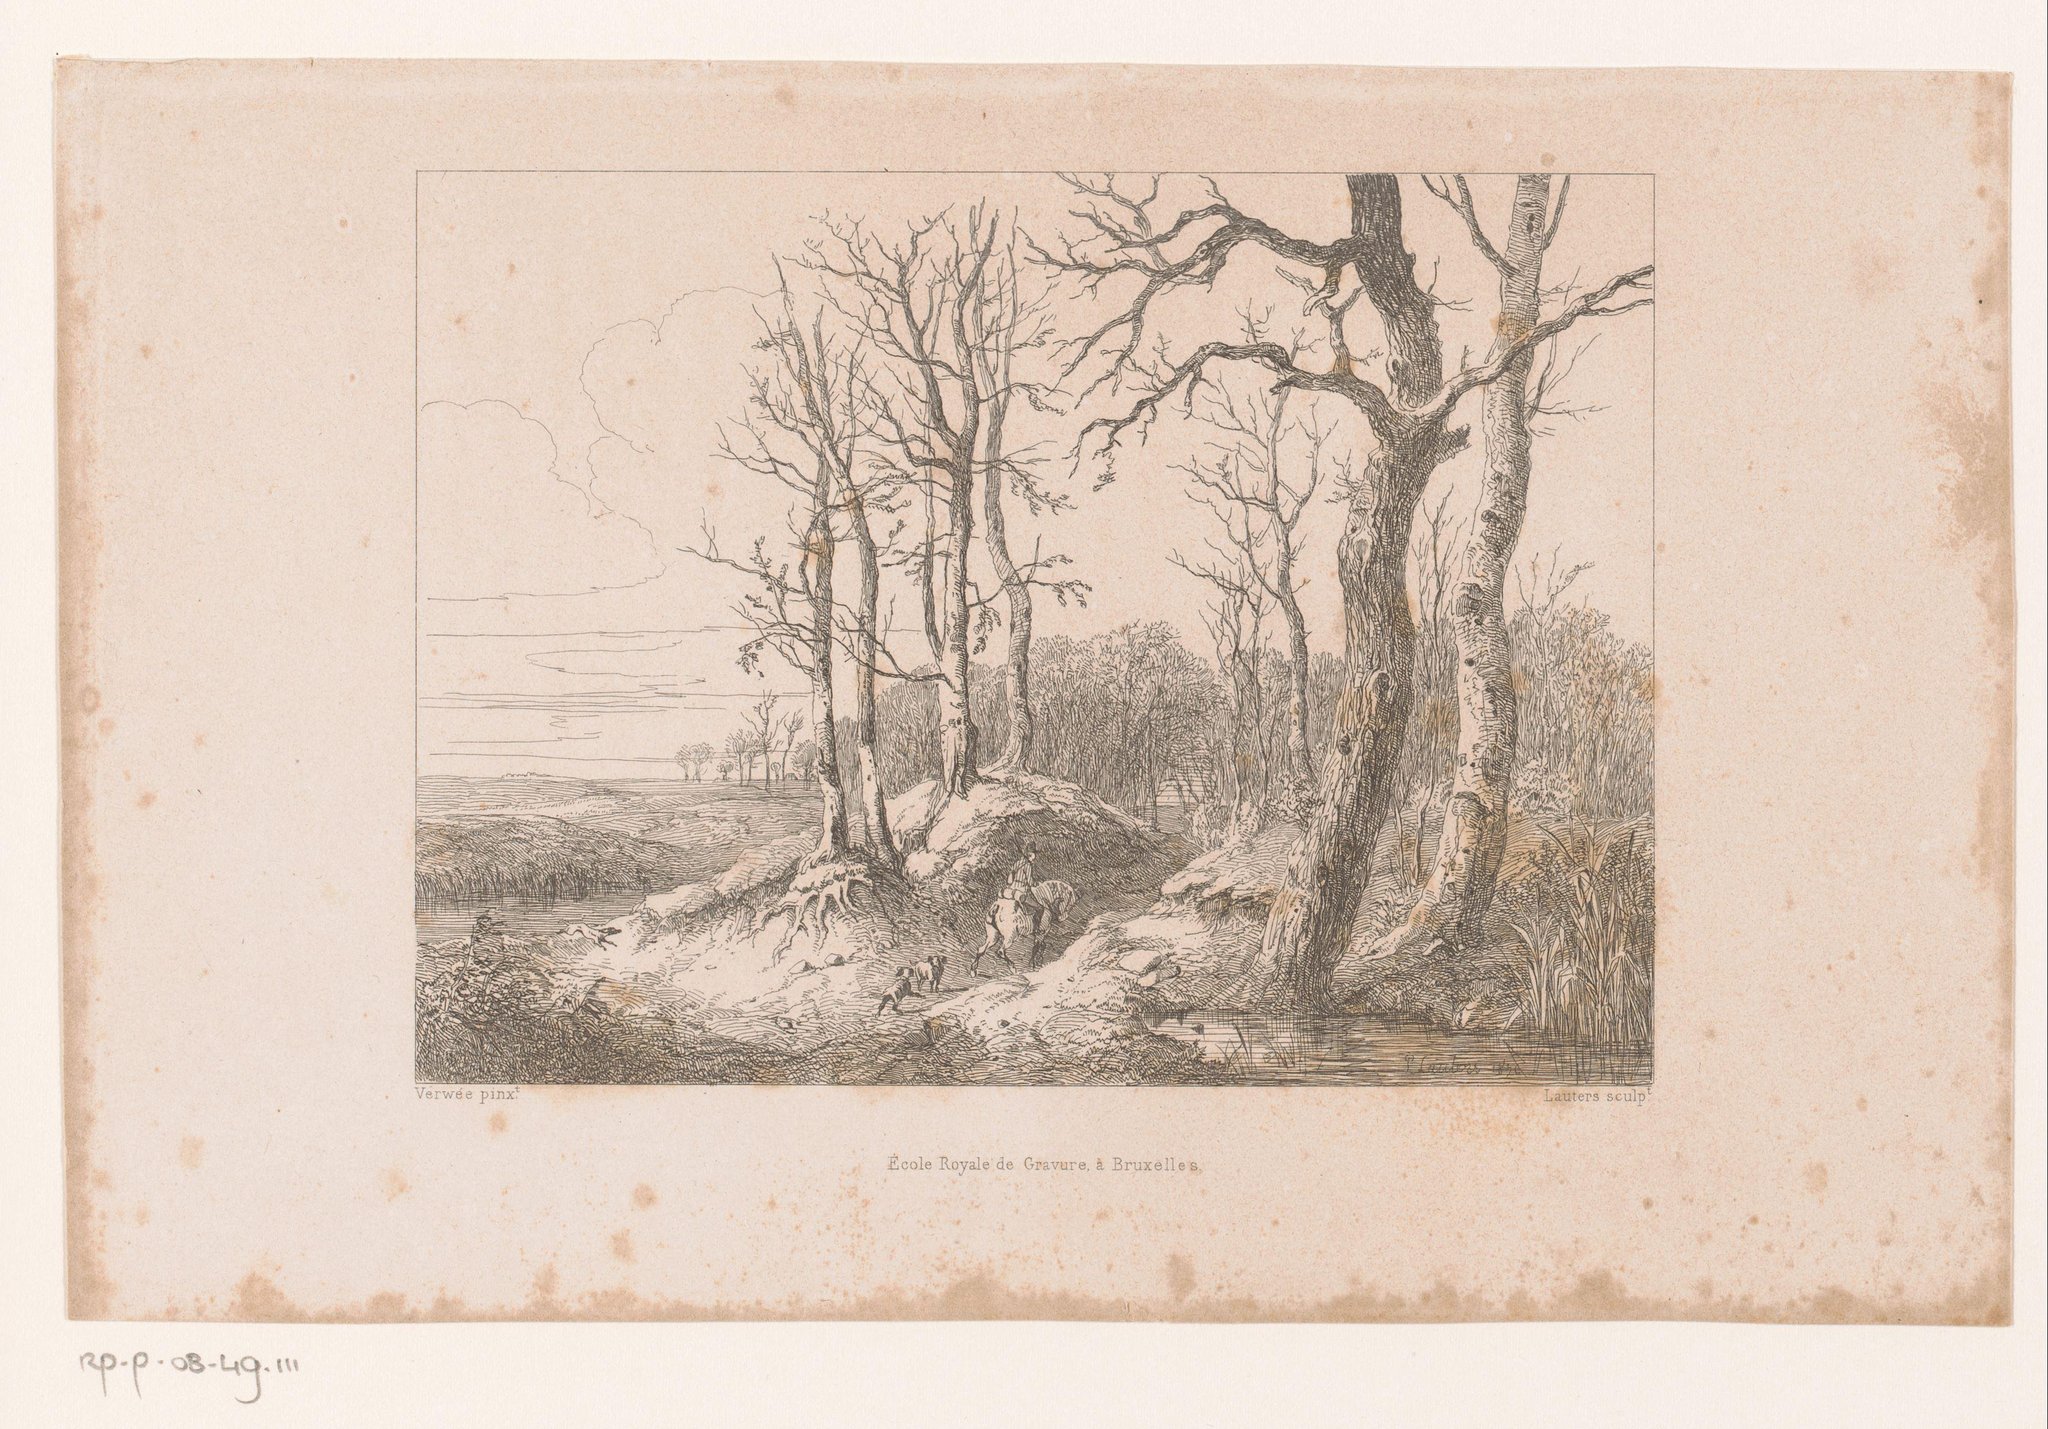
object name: book illustration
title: Hiver, intérieur de bois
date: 1836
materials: paper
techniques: etching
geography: brussels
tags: hunting dogs, hunter, deciduous forest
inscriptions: collector's mark: Lugt 2228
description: Prent uit: Alvin, Louis. Compte-rendu du salon d'exposition de Bruxelles, 1836. Brussel: J.P. Meline, 1836, p. 135.